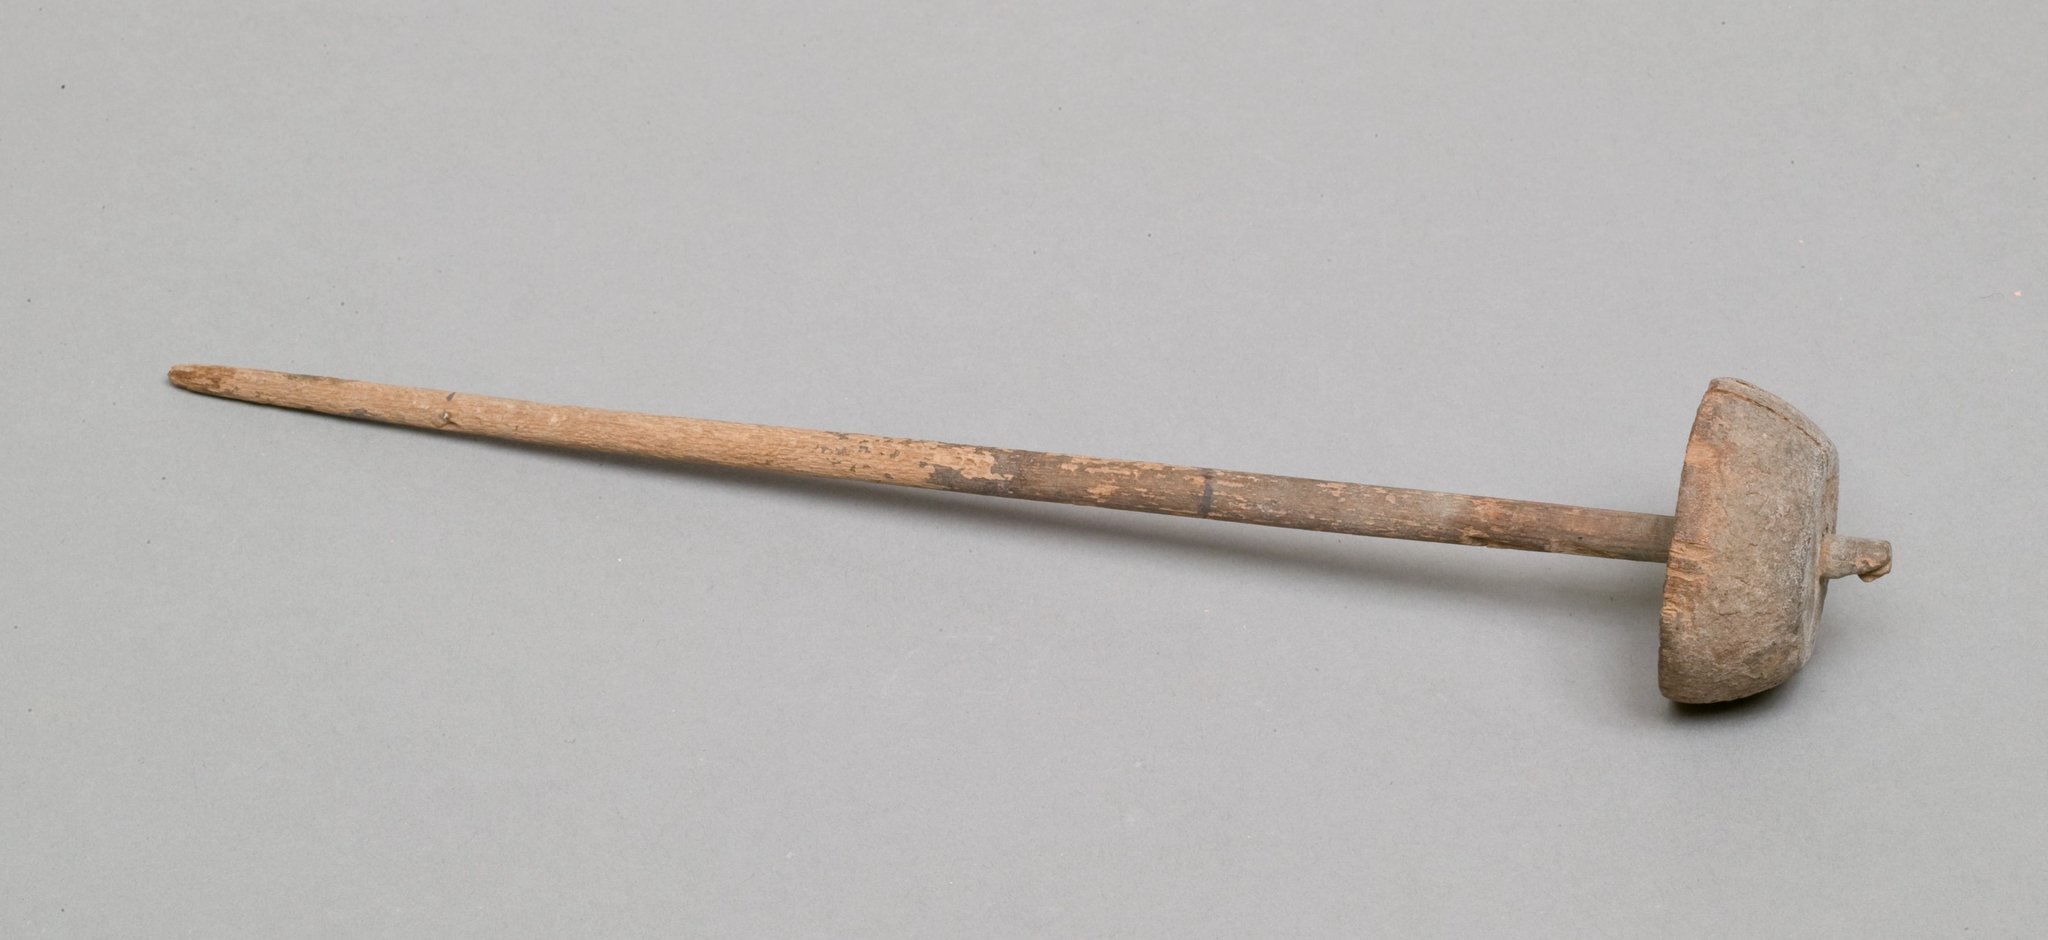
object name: spindle whorl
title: Spindle with whorl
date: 1295-1070 BCE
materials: wood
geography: egypt